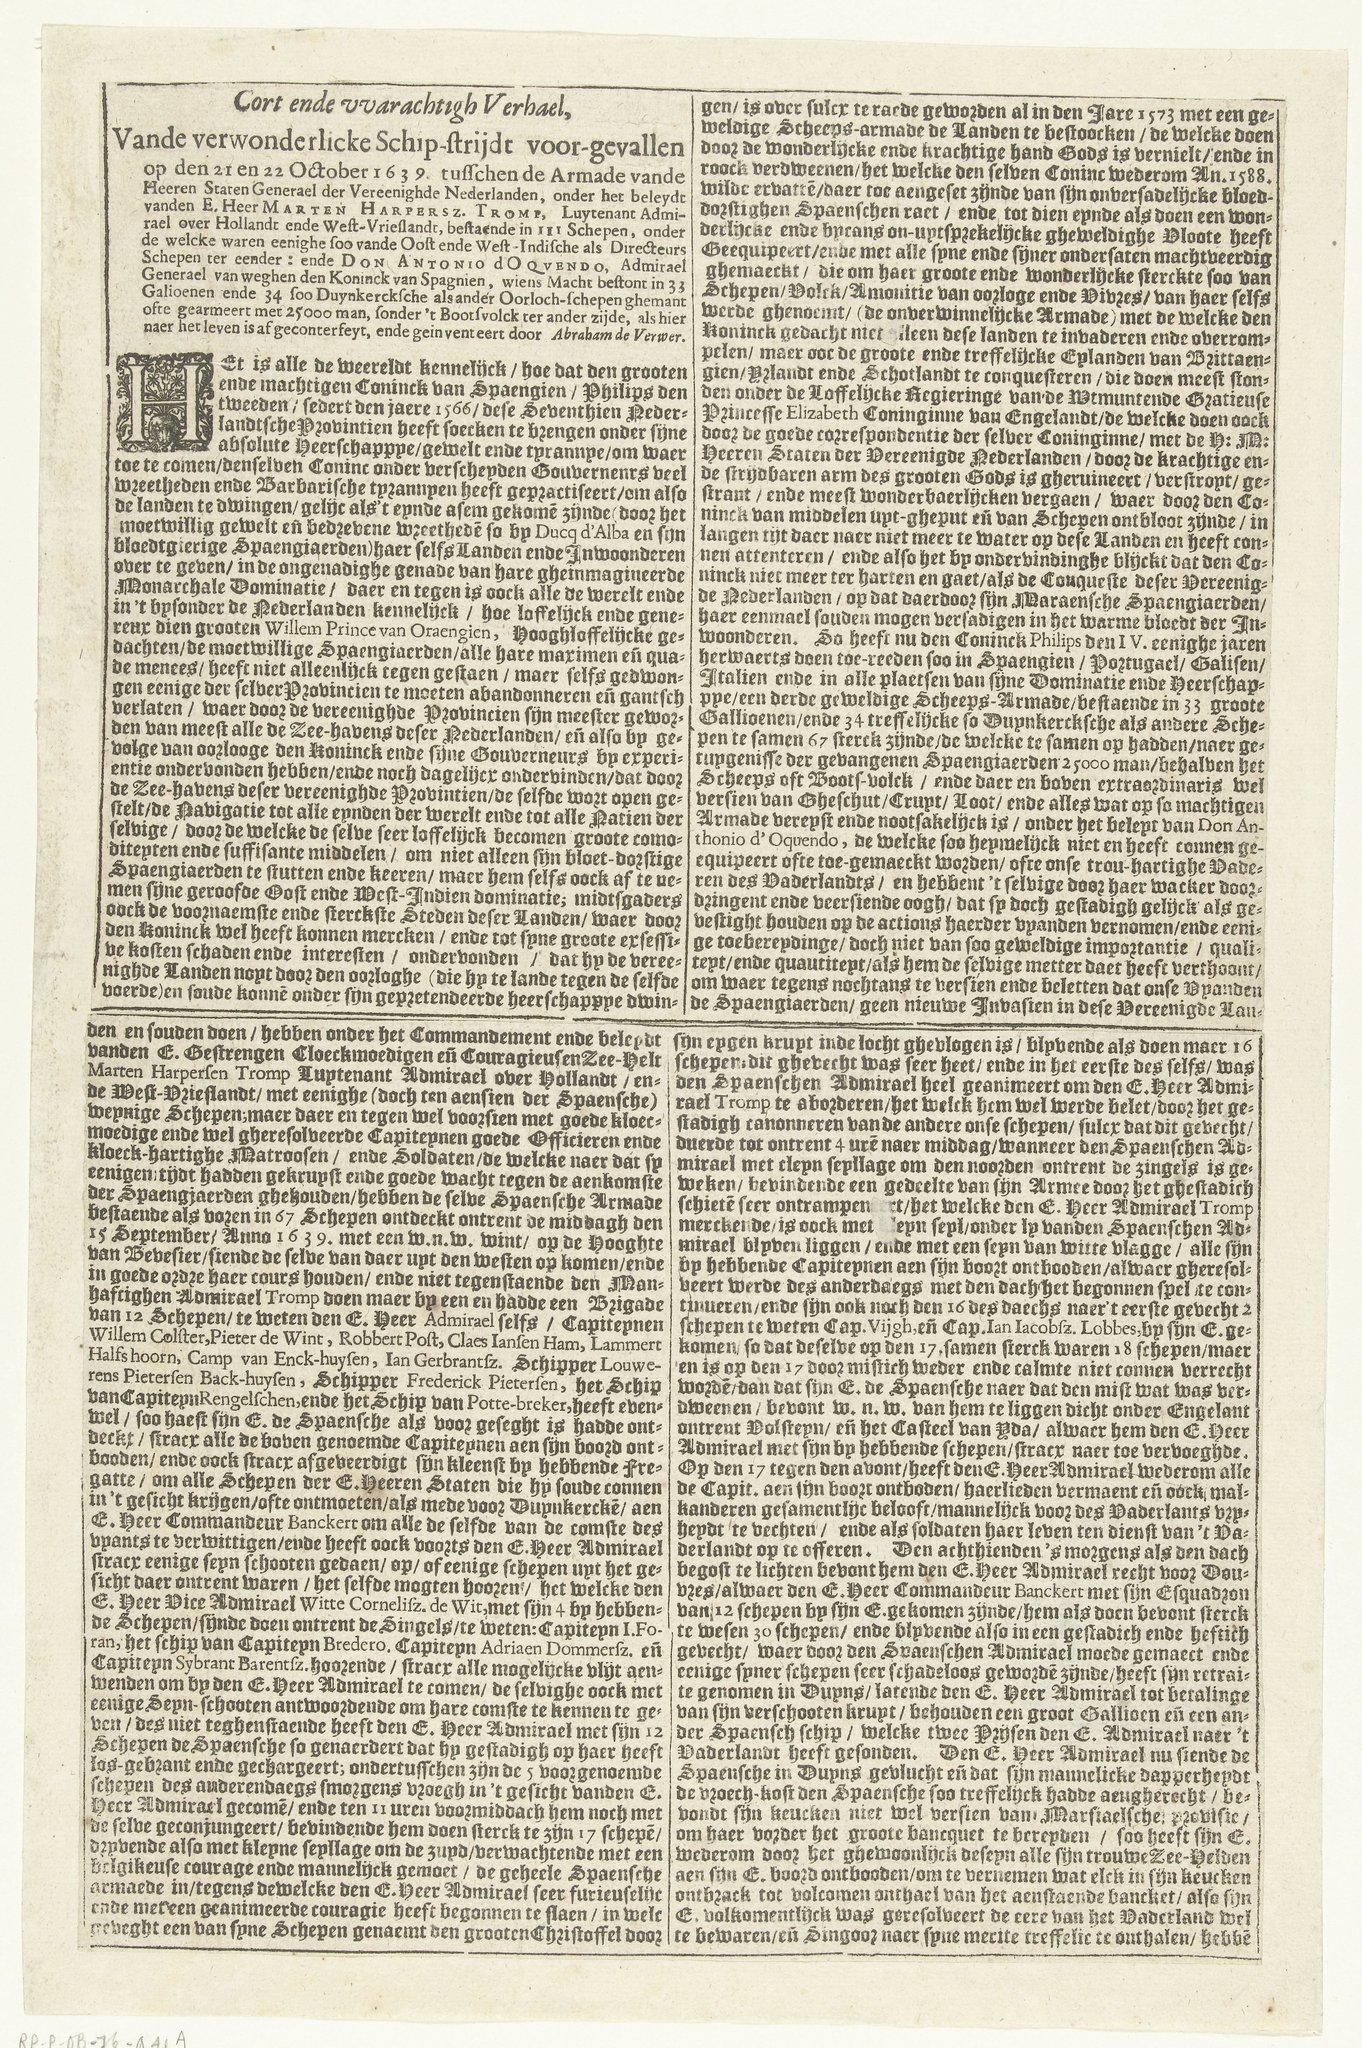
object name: text sheet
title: Cort ende warachtigh Verhael, Vande verwonderlicke Schip-strijdt voor-gevallen op den 21 en 22 October 1639. tusschen de Armade van de Heeren Staten Generael der Vereenighde Nederlanden, onder het beleydt van den E. Heer Marten Harpersz. Tromp (...) ende Don Antonio d'Oquendo, Admirael Generael van weghen den Koninck van Spagnien (...)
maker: salomon savery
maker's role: print maker, publisher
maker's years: 1594-1683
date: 1640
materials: paper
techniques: letterpress printing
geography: amsterdam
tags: maarten harpertszoon tromp, battle of the downs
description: Tekstblad bij de prent van de zeeslag bij Duins tussen de Spaanse vloot onder bevel van Antonio de Oquendo en de Staatse vloot onder Maarten Harpertsz. Tromp, 21 oktober 1639. Blad met 2 keer 2 kolommen tekst in het Nederlands. De linker tekstblad in een ongemonteerd ensemble bestaande uit een grote voorstelling in twee platen en twee tekstbladen.